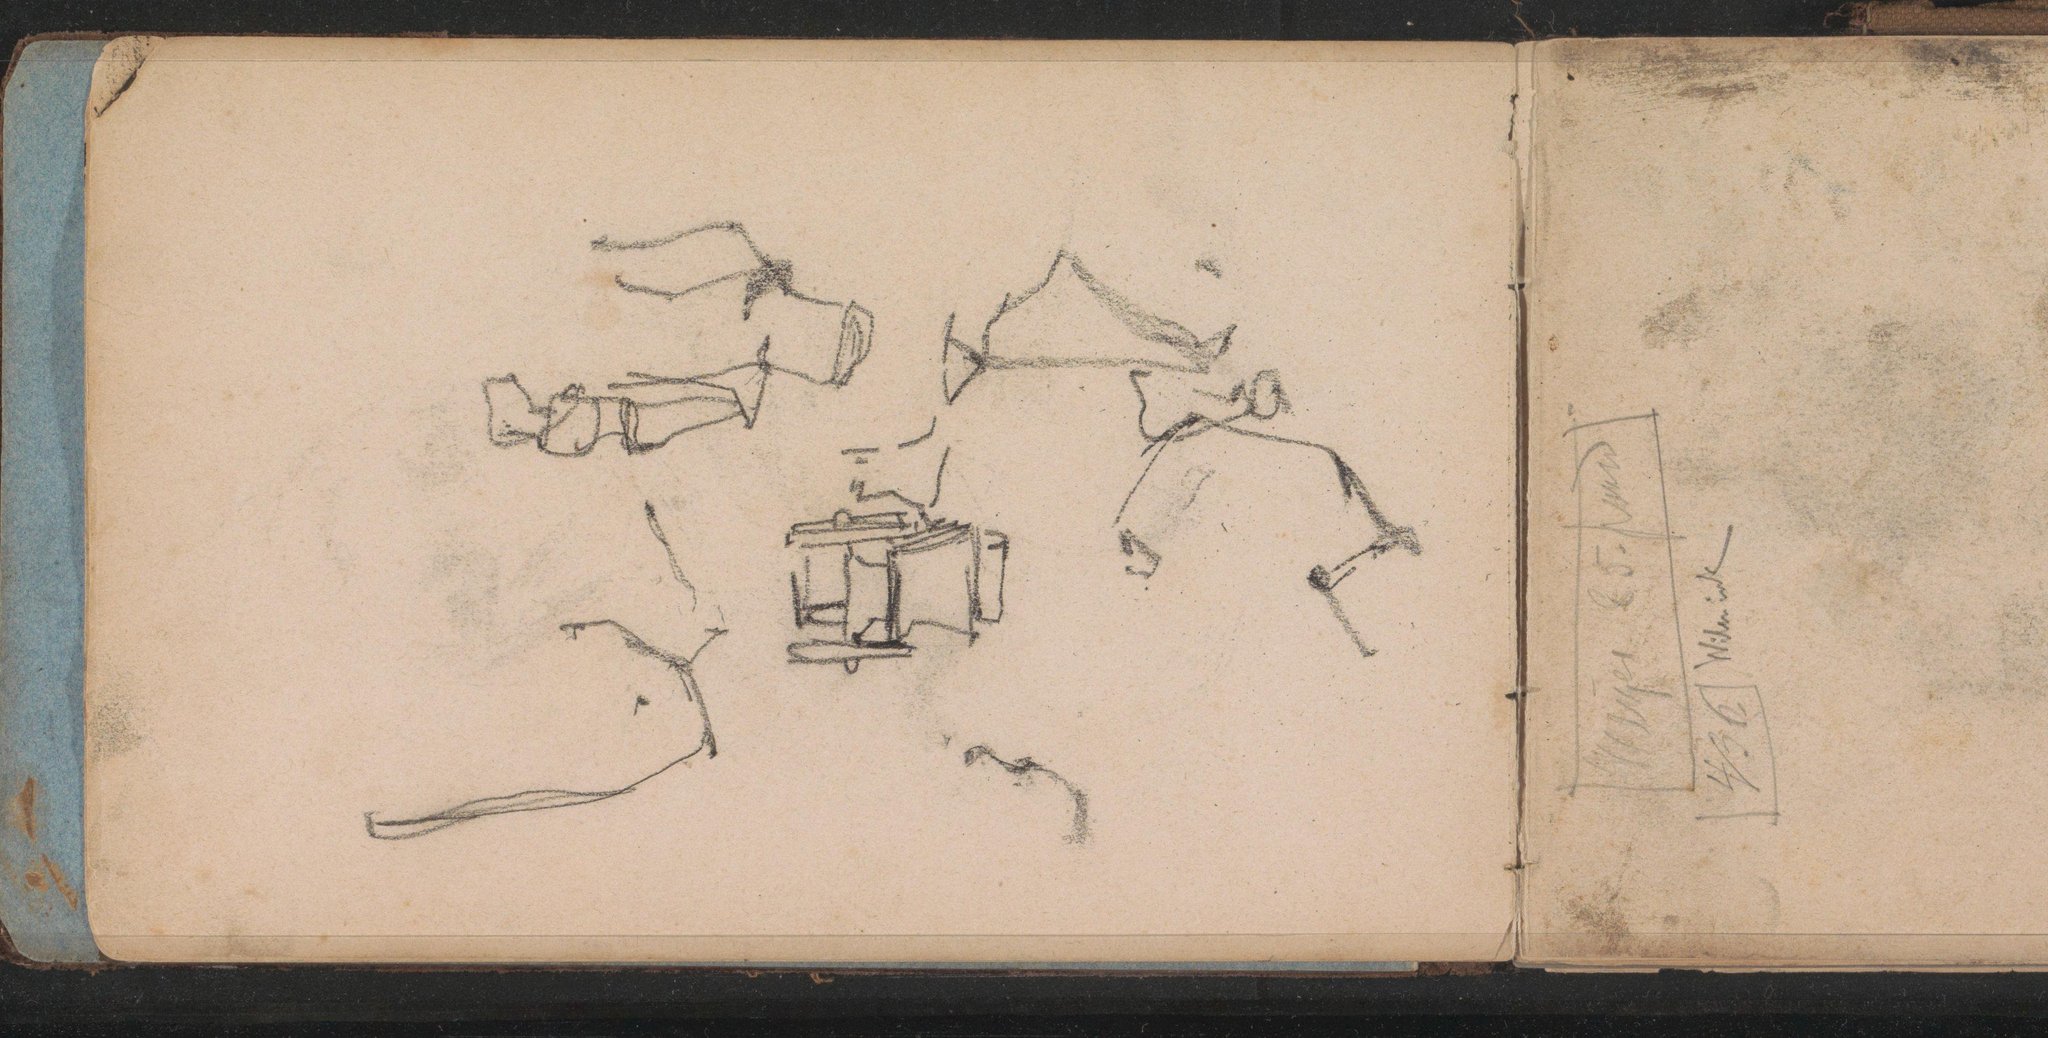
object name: sketchbook leaf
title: Figuurstudies en een paard-en-wagen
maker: george hendrik breitner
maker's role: draughtsman, painter, print maker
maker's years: 1857-1923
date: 1880-1882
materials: chalk, paper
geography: scheveningen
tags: adult man, four-wheeled, animal-drawn vehicle, e.g.: cab, carriage, coach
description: Pagina 5 uit een schetsboek met 37 bladen.